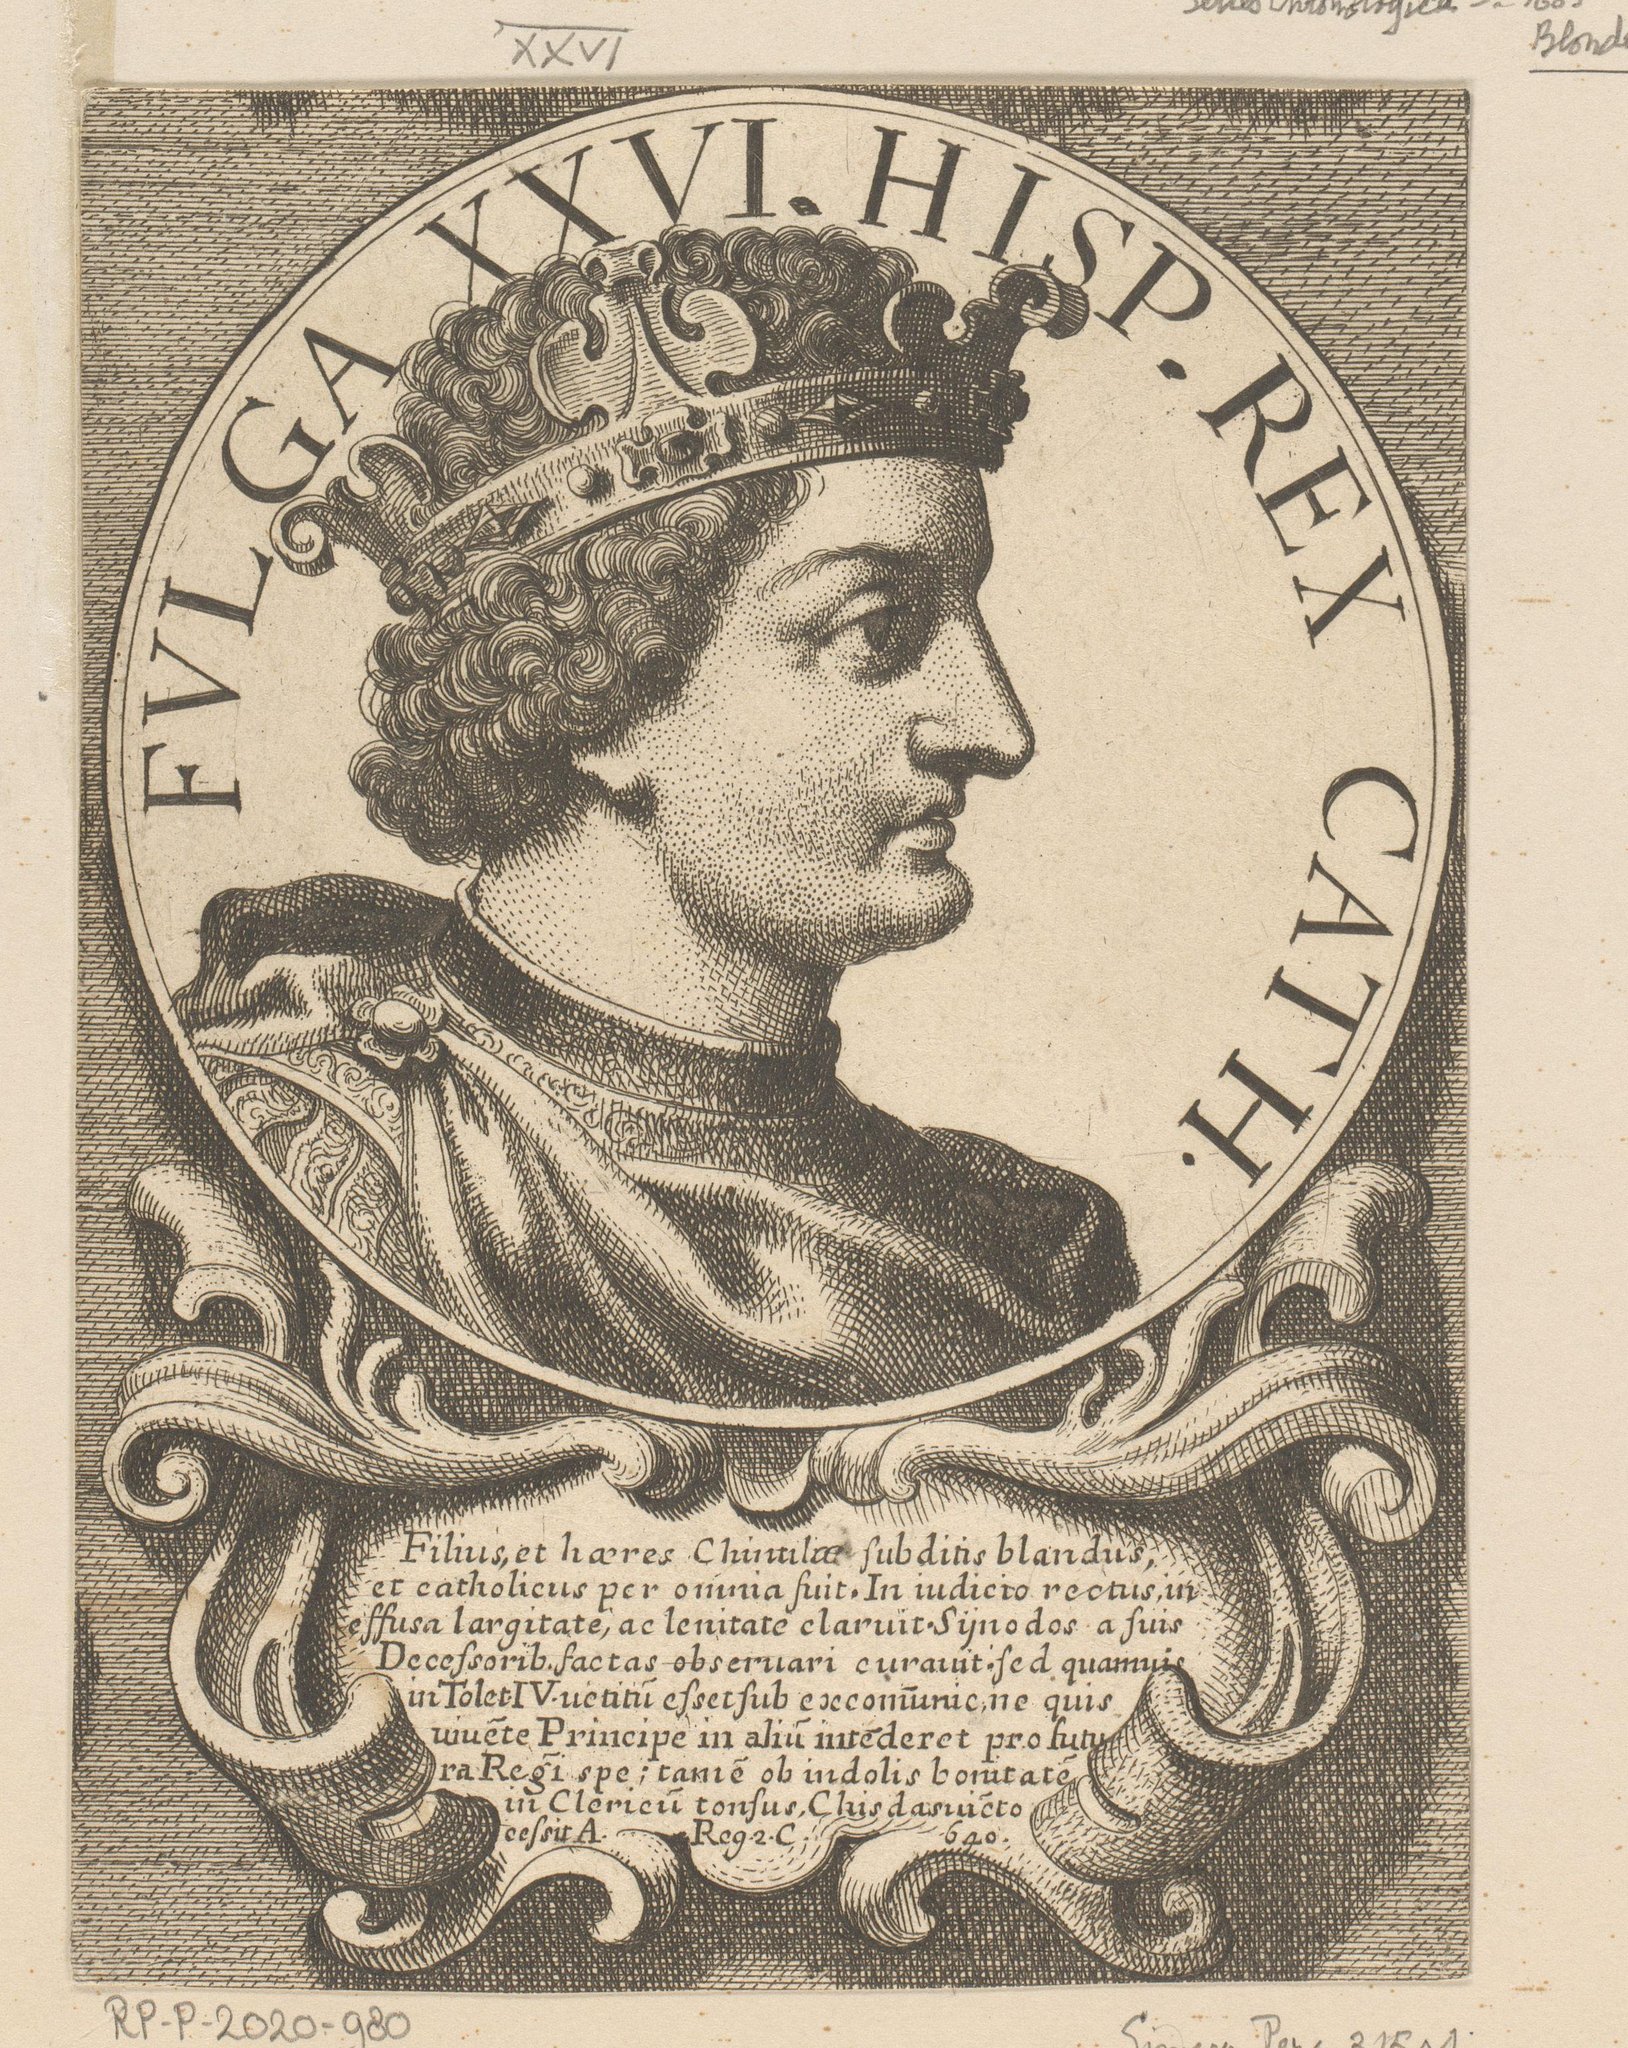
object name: print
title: Fulga XXVI Hisp Rex Cath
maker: arnold van westerhout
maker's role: print maker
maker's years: 1651-1725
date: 1684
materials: paper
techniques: engraving, etching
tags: historical persons, ruler, sovereign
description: Portret ook gebruikt in: Niphus, Agustinus. Effigies et series regum Hispaniae primum ex Gothis Christianorum (...). Rome: s.n., 1684.